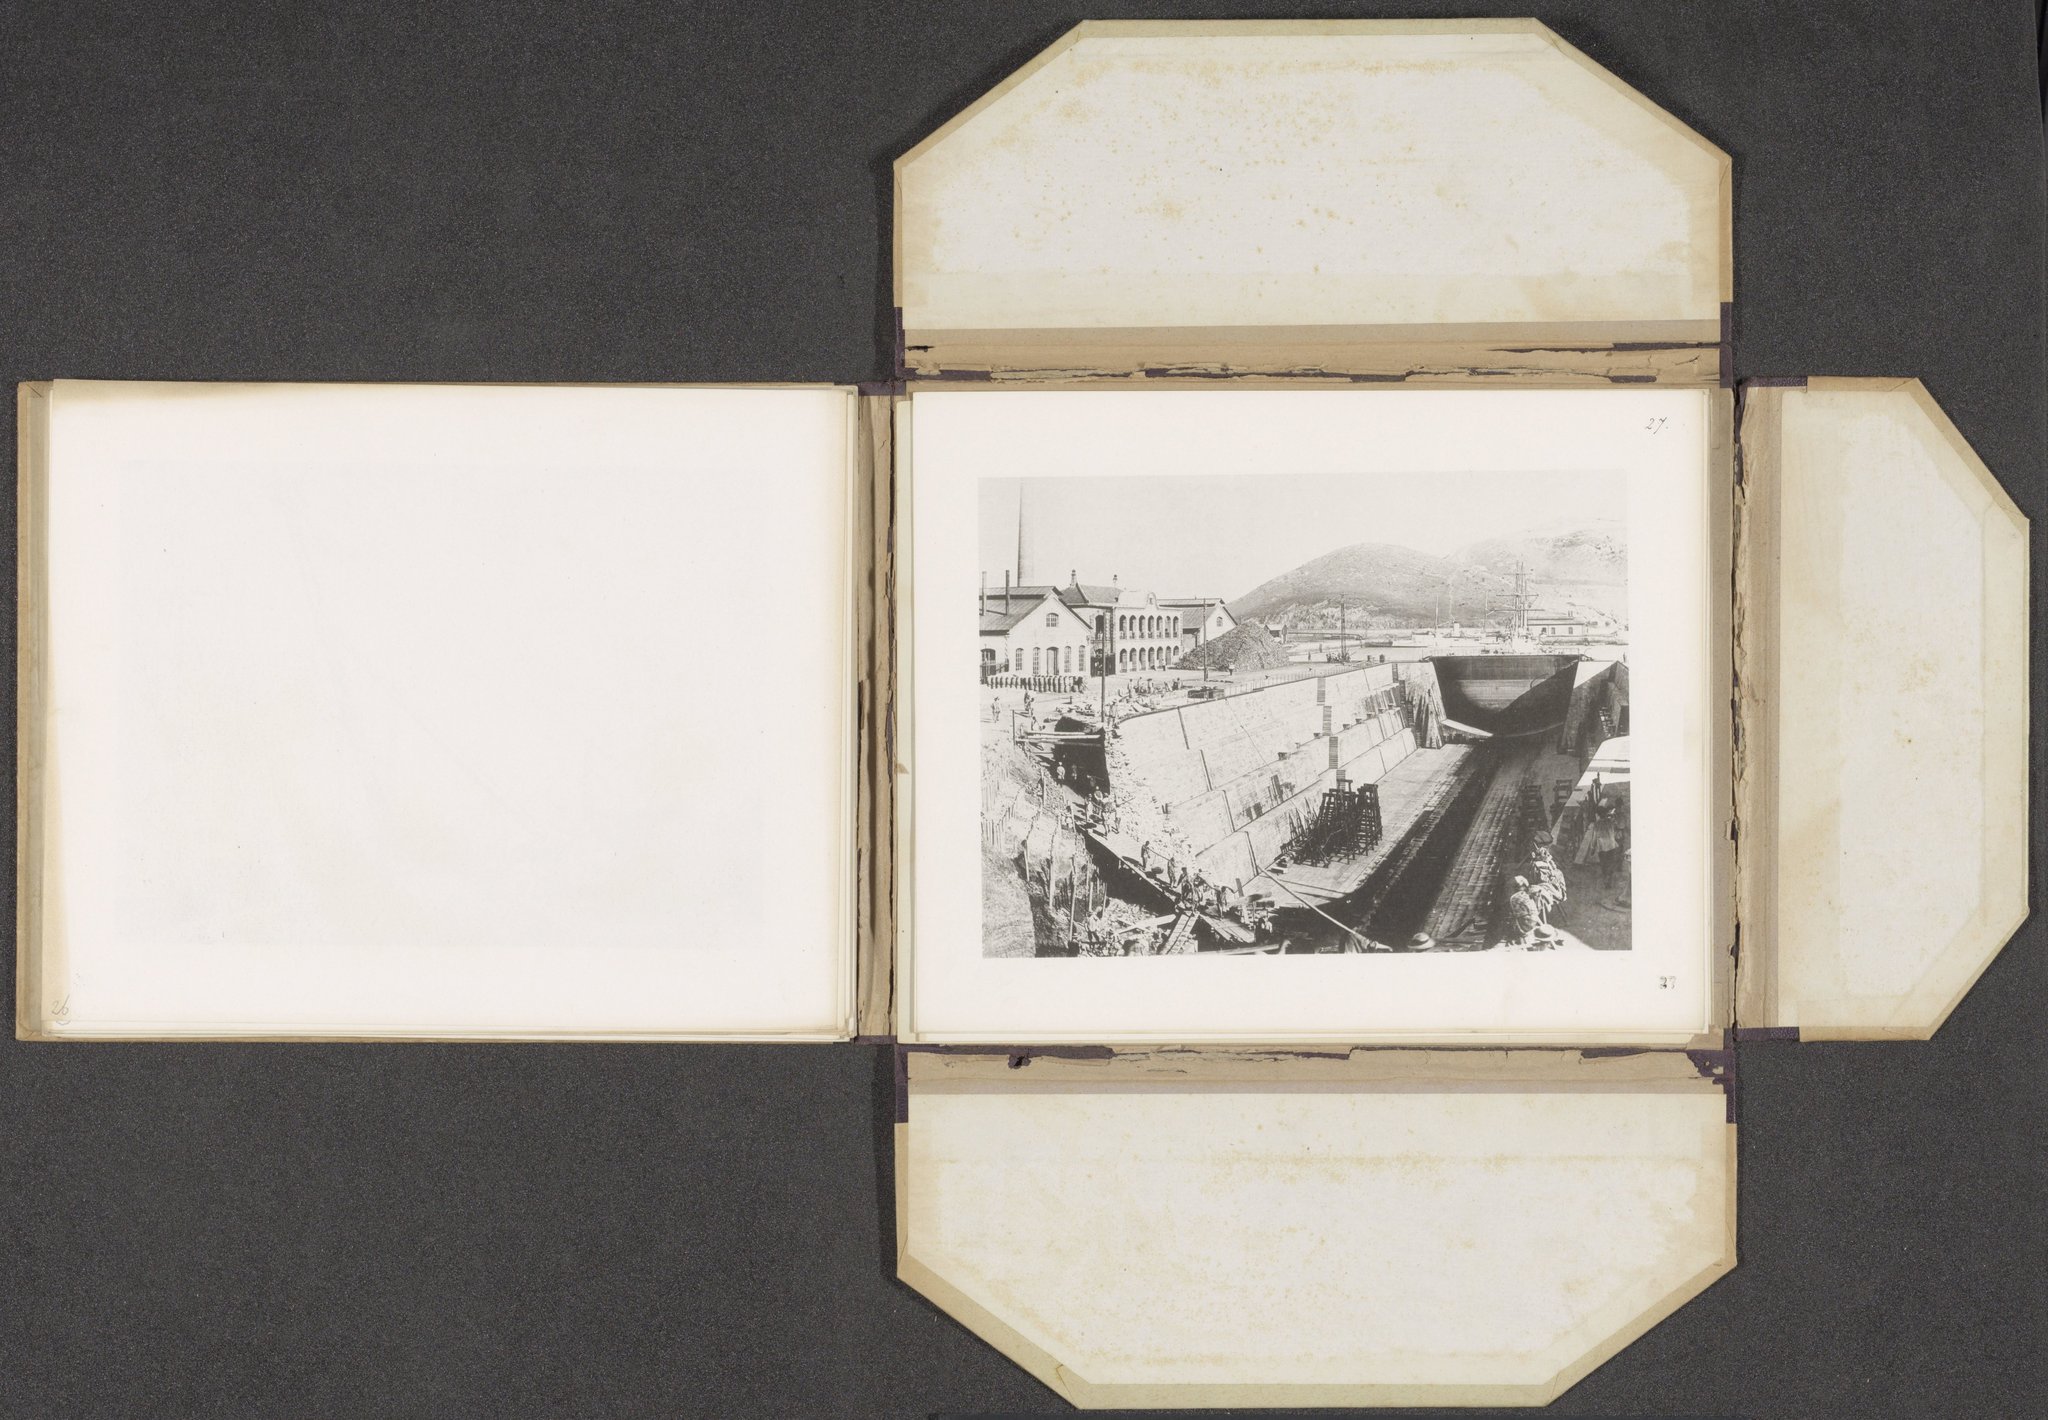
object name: page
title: Gezicht op een droogdok te Port Arthur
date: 1898-1899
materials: paper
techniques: photograph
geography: port arthur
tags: dock labourer, dry-dock, floating-dock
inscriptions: number: ‘27’